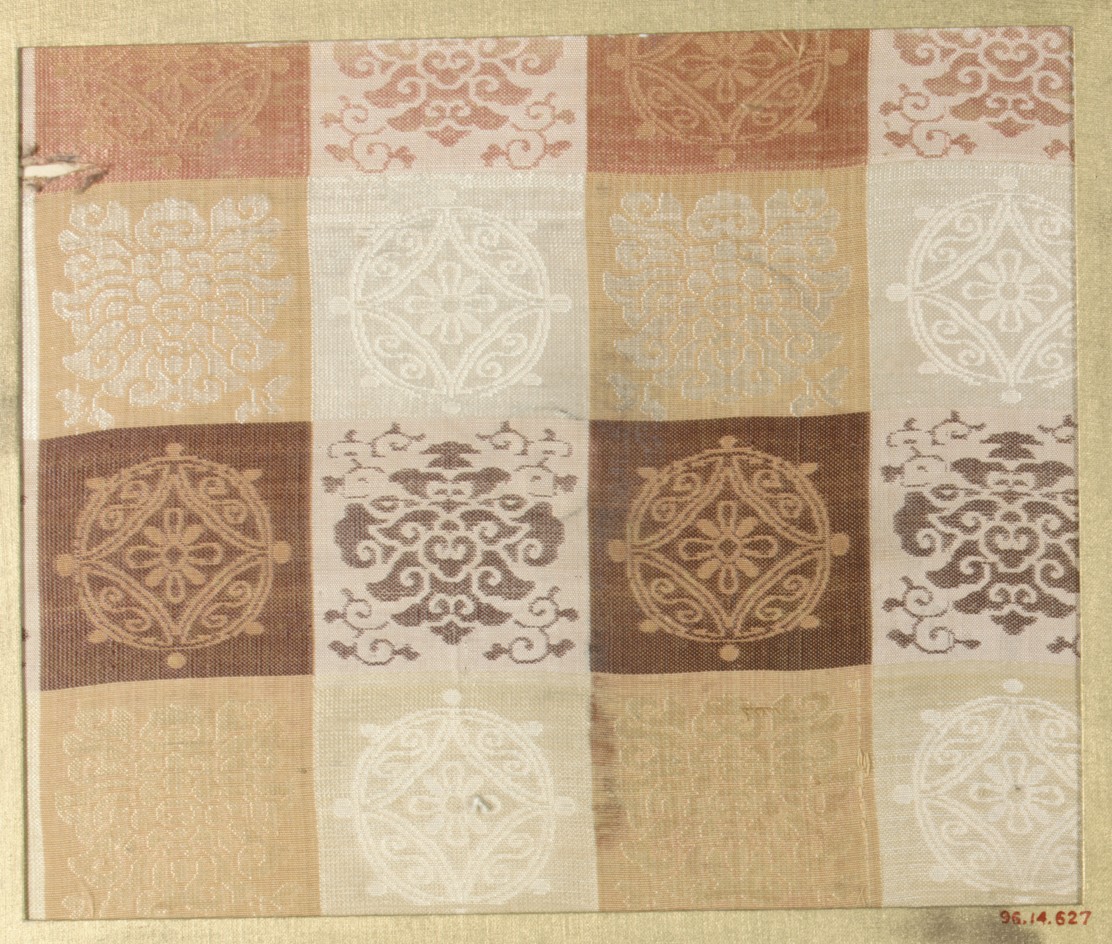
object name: piece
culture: japanese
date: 1701-1900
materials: silk